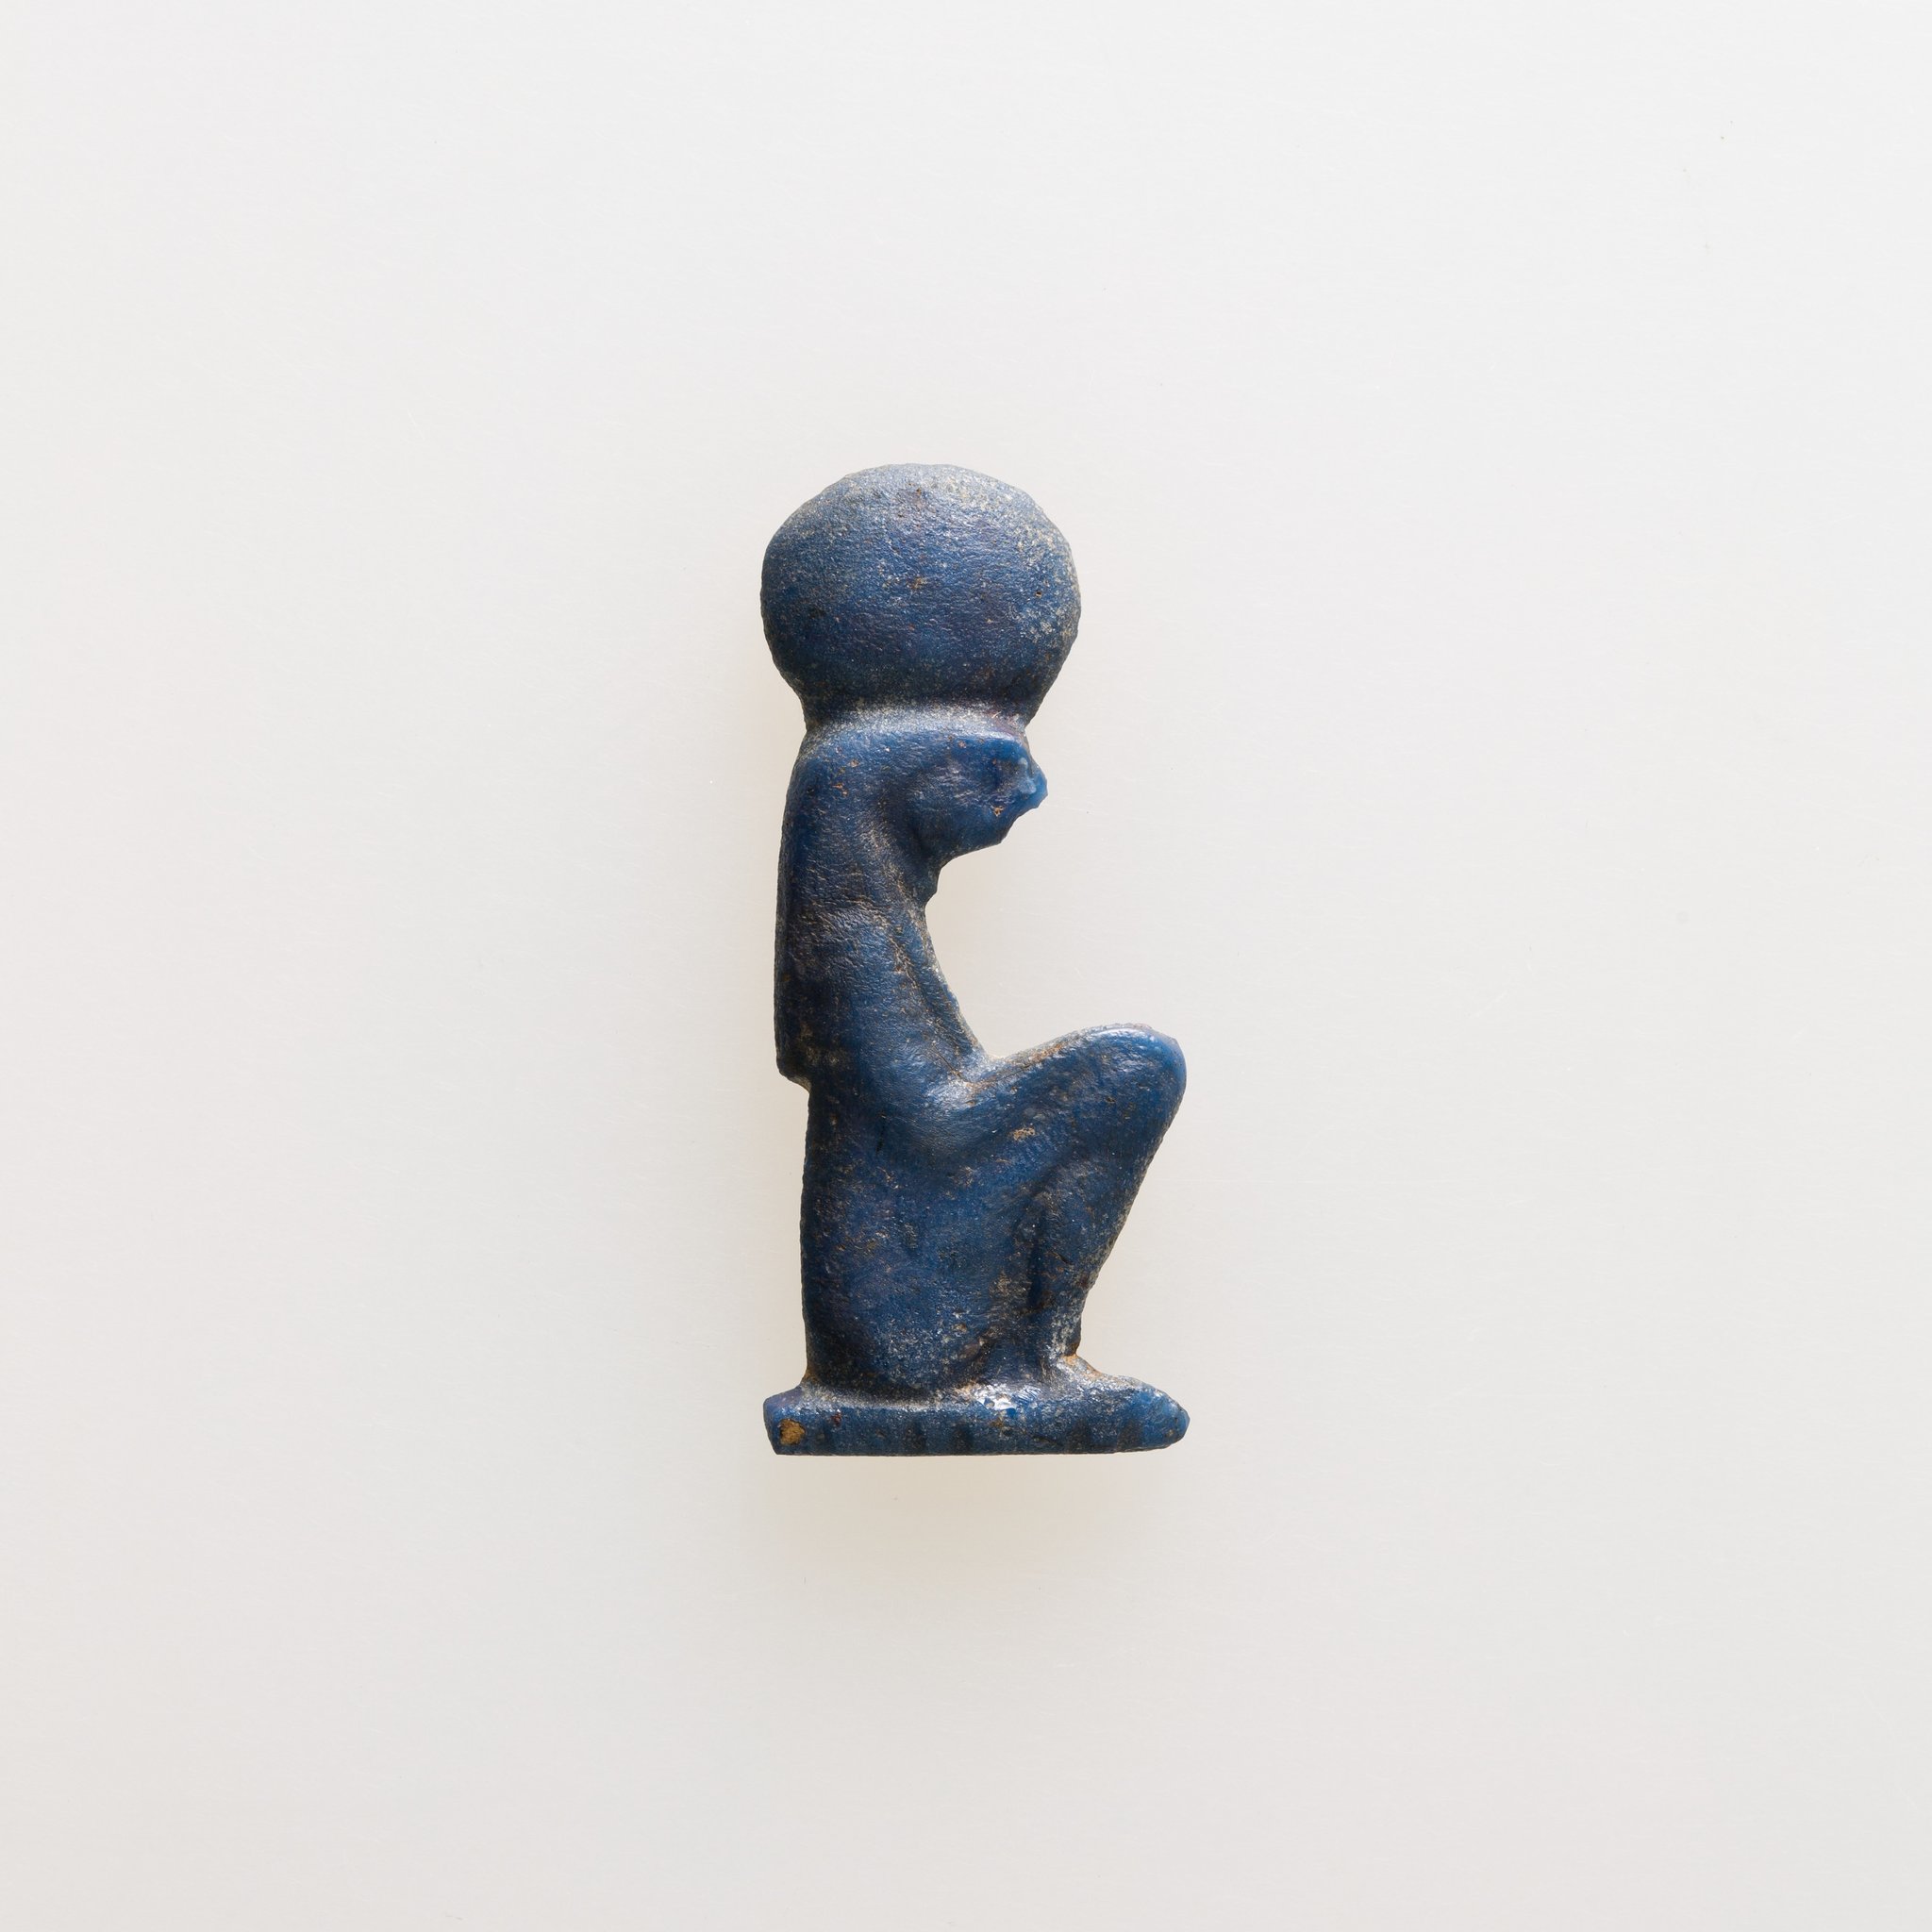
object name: amulet, re, sundisk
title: Amulet of Re-Harakhty squatting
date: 525-30 BCE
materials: glass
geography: egypt